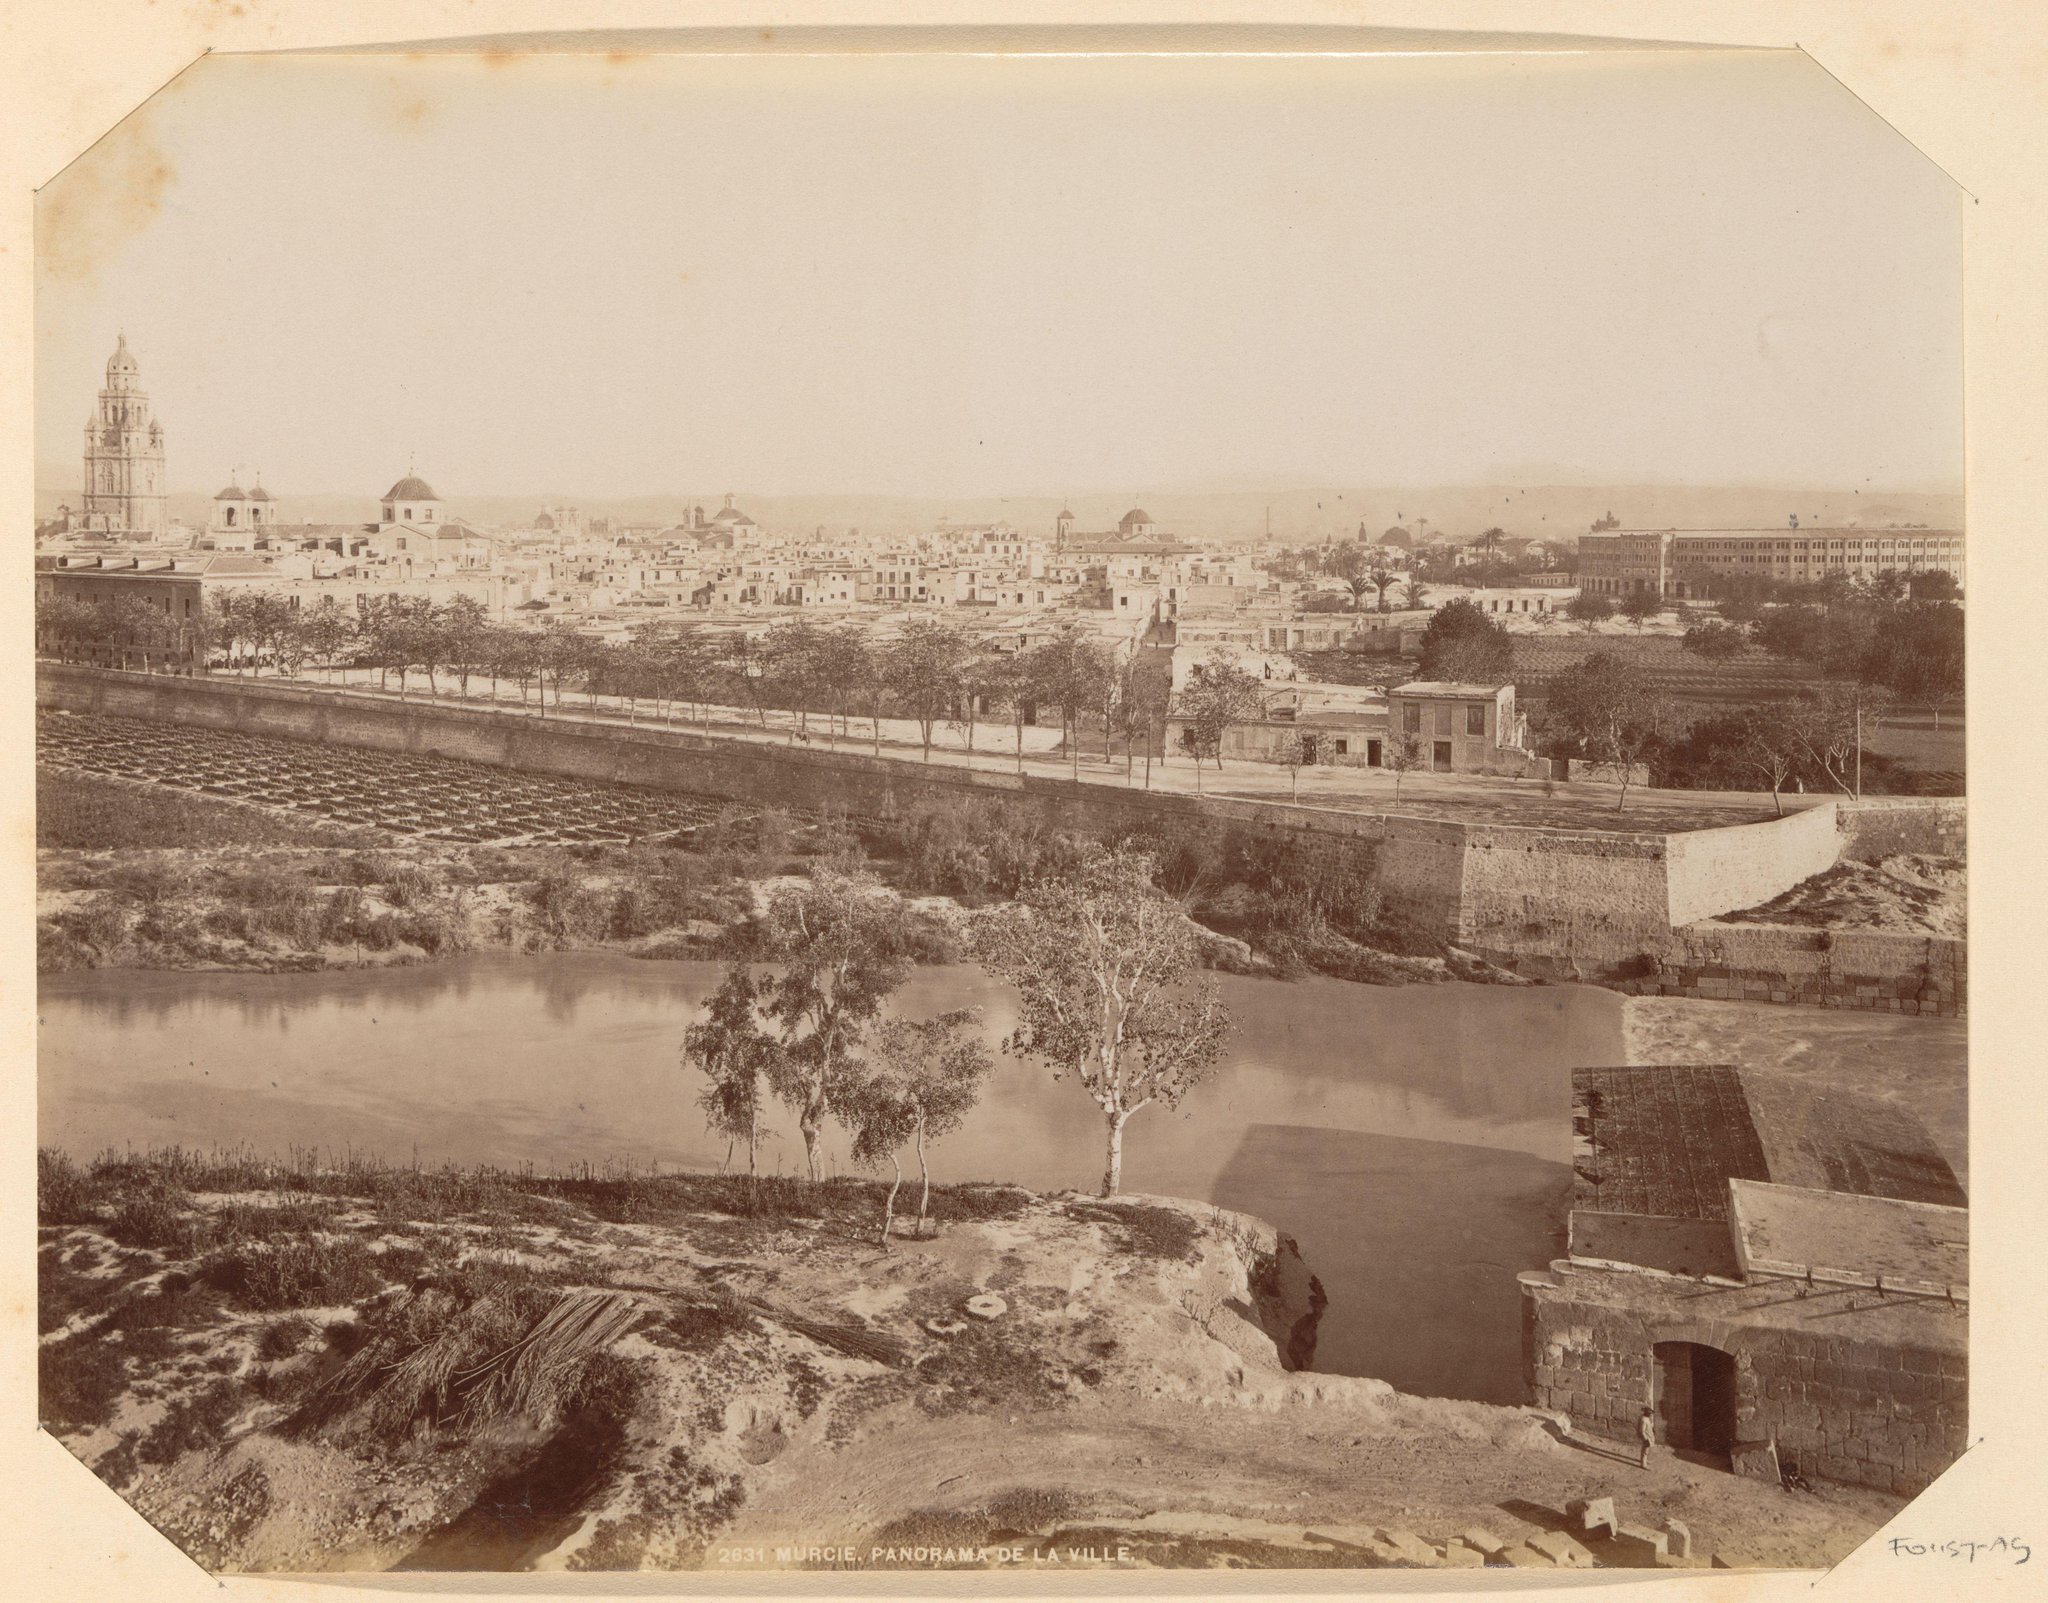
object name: photograph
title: Murcie. Panorama de la ville.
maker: Anonymous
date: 1885-1892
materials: photographic support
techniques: albumen print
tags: city-view in general; 'veduta', canals, waters (in city)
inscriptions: number: ‘2831’, annotation: ‘Murcia - Panorama’